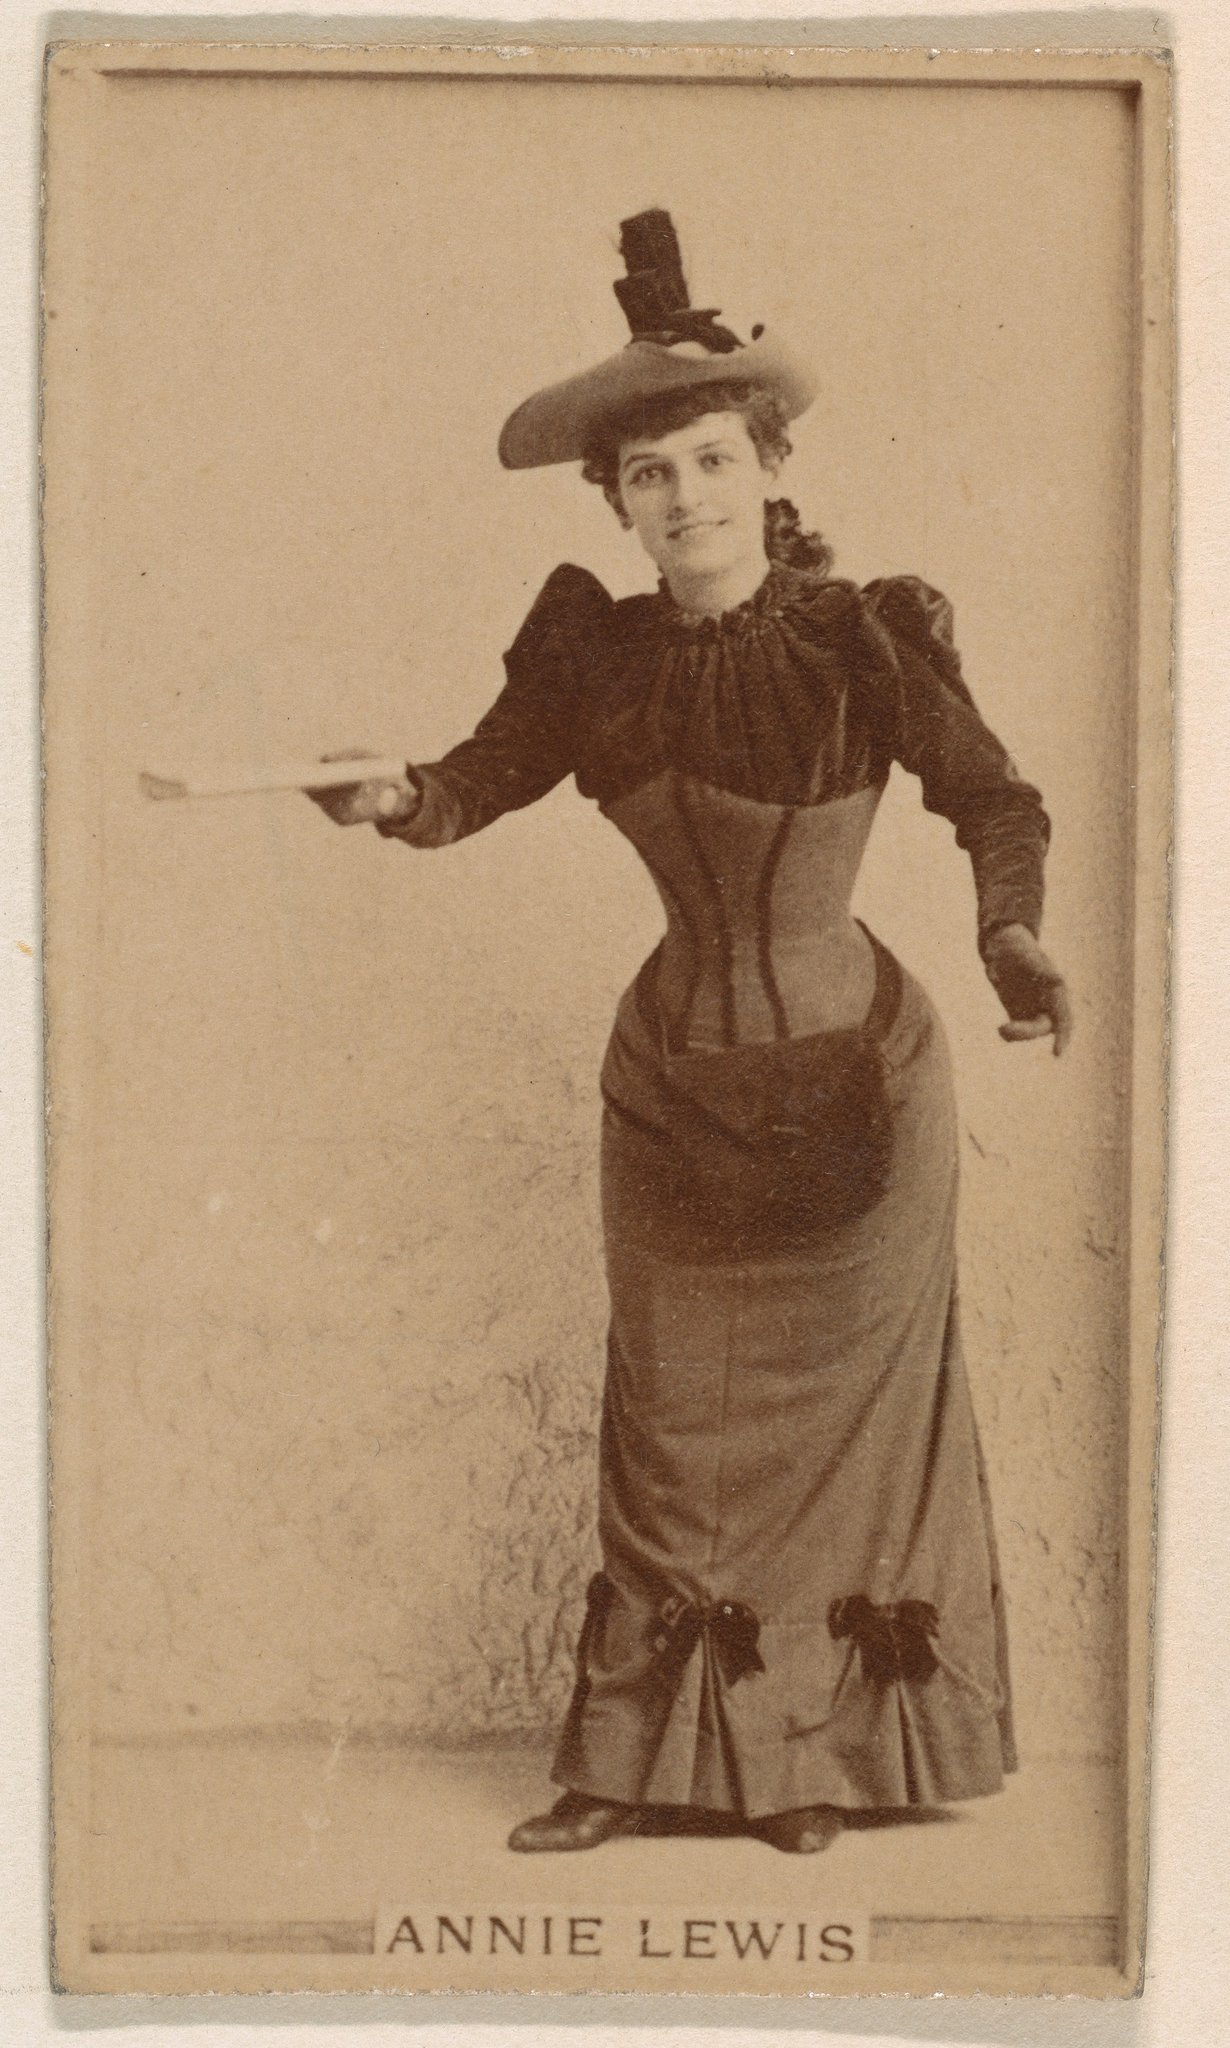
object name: photograph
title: Annie Lewis, from the Actresses series (N245) issued by Kinney Brothers to promote Sweet Caporal Cigarettes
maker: kinney brothers tobacco company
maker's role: publisher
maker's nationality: american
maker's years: 1869-2011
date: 1890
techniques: albumen silver print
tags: portraits,women,actresses